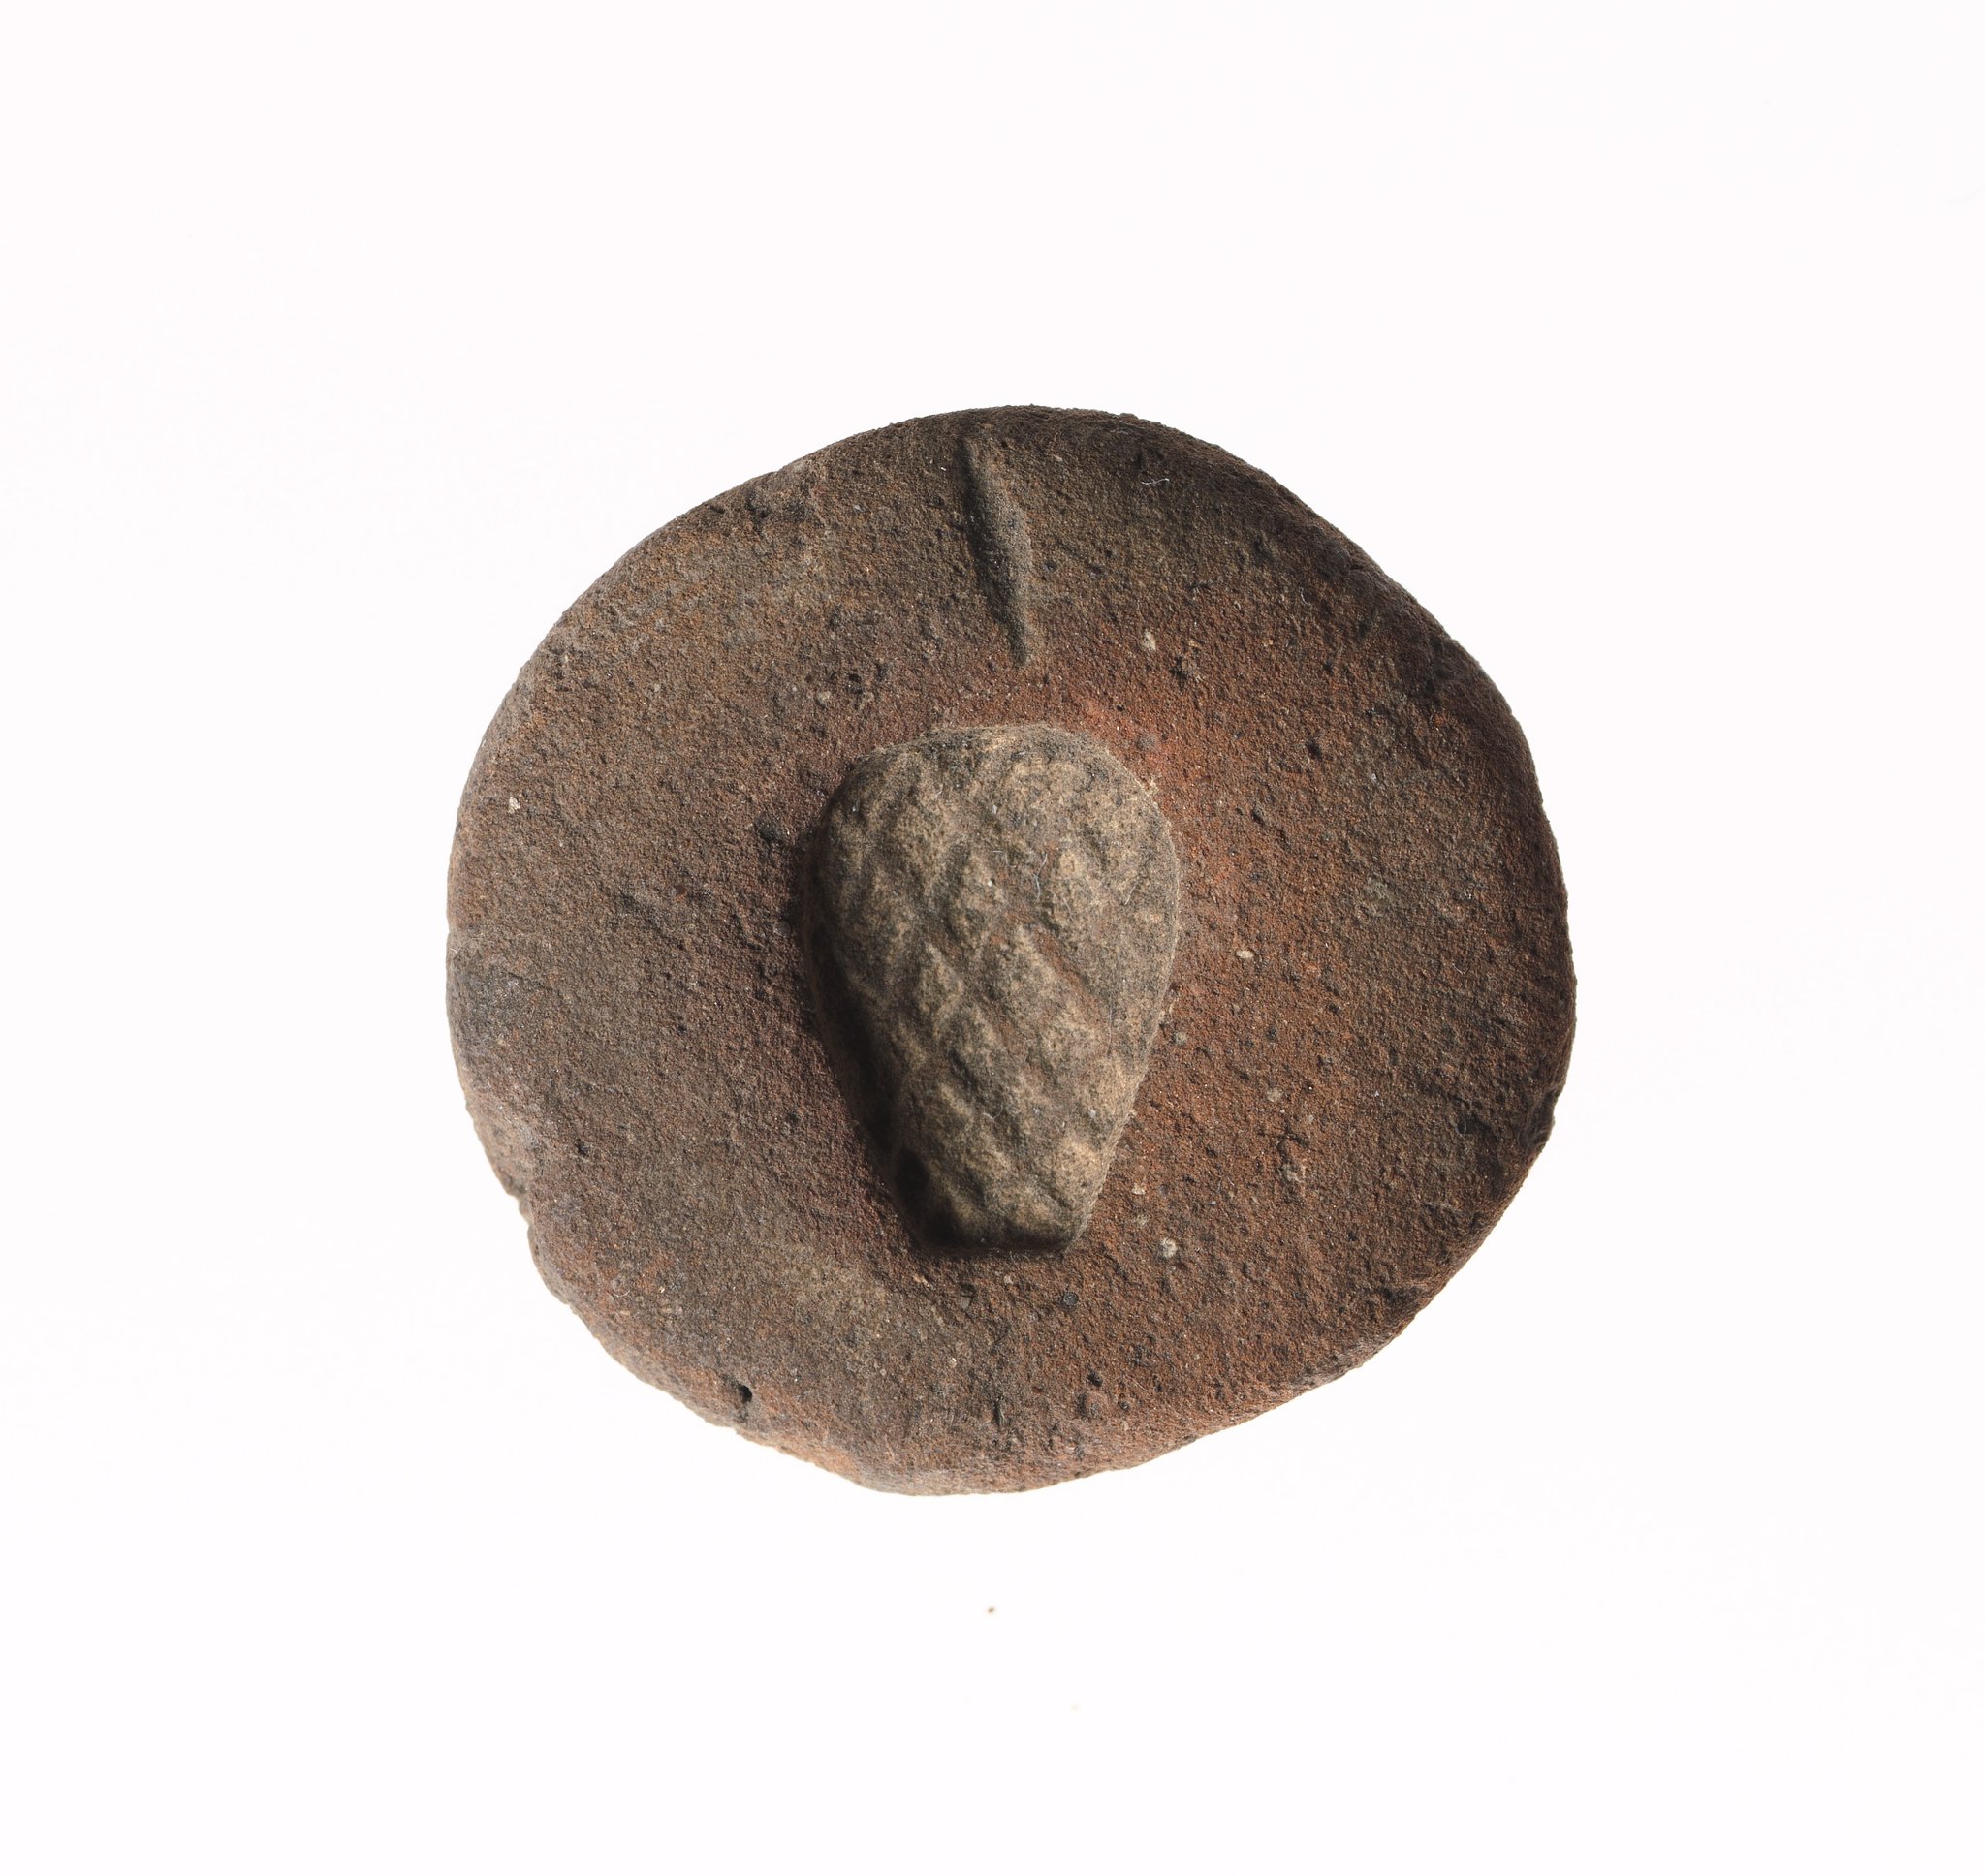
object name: mold, umbel of cornflower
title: Mold for Umbel of Cornflower Pendant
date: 1353-1336 BCE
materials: pottery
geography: egypt